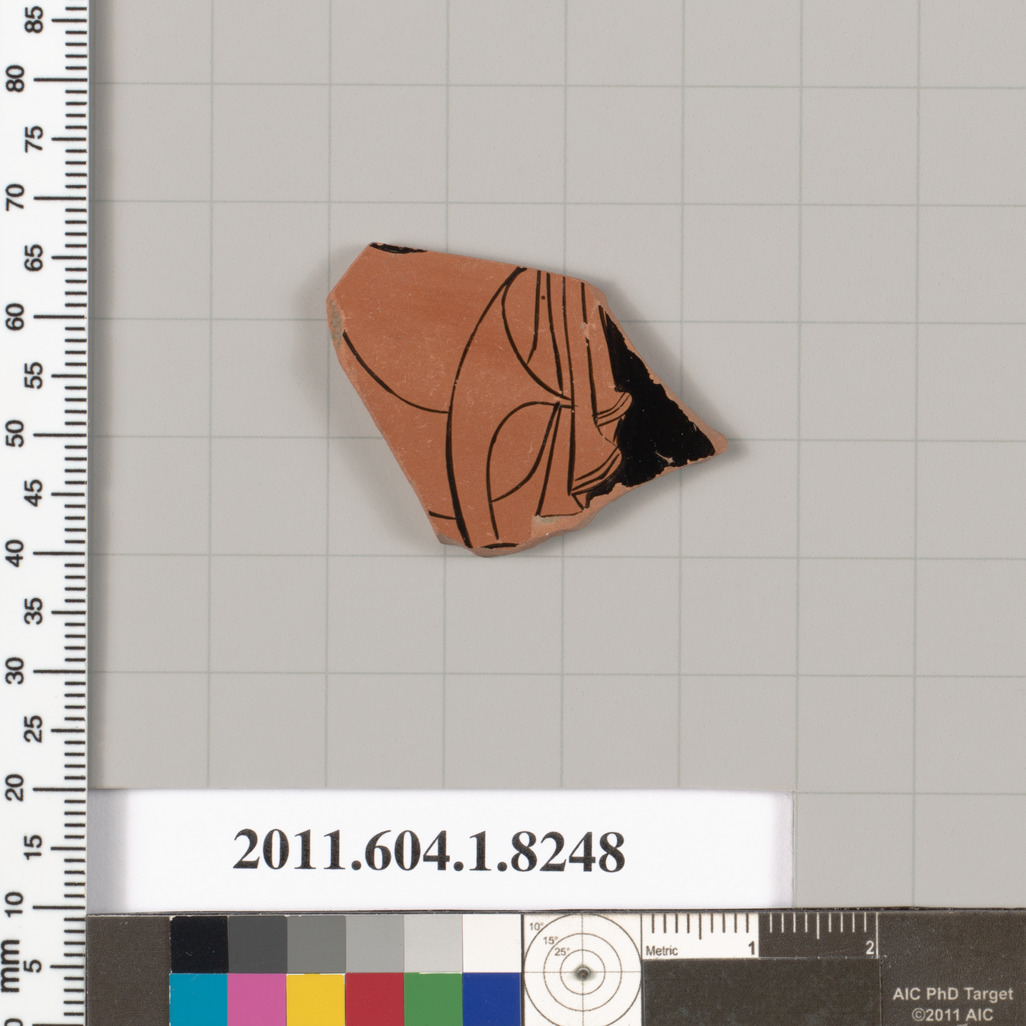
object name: kylix fragment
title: Terracotta fragment of a kylix (drinking cup)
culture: greek, attic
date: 520-510 BCE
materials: terracotta